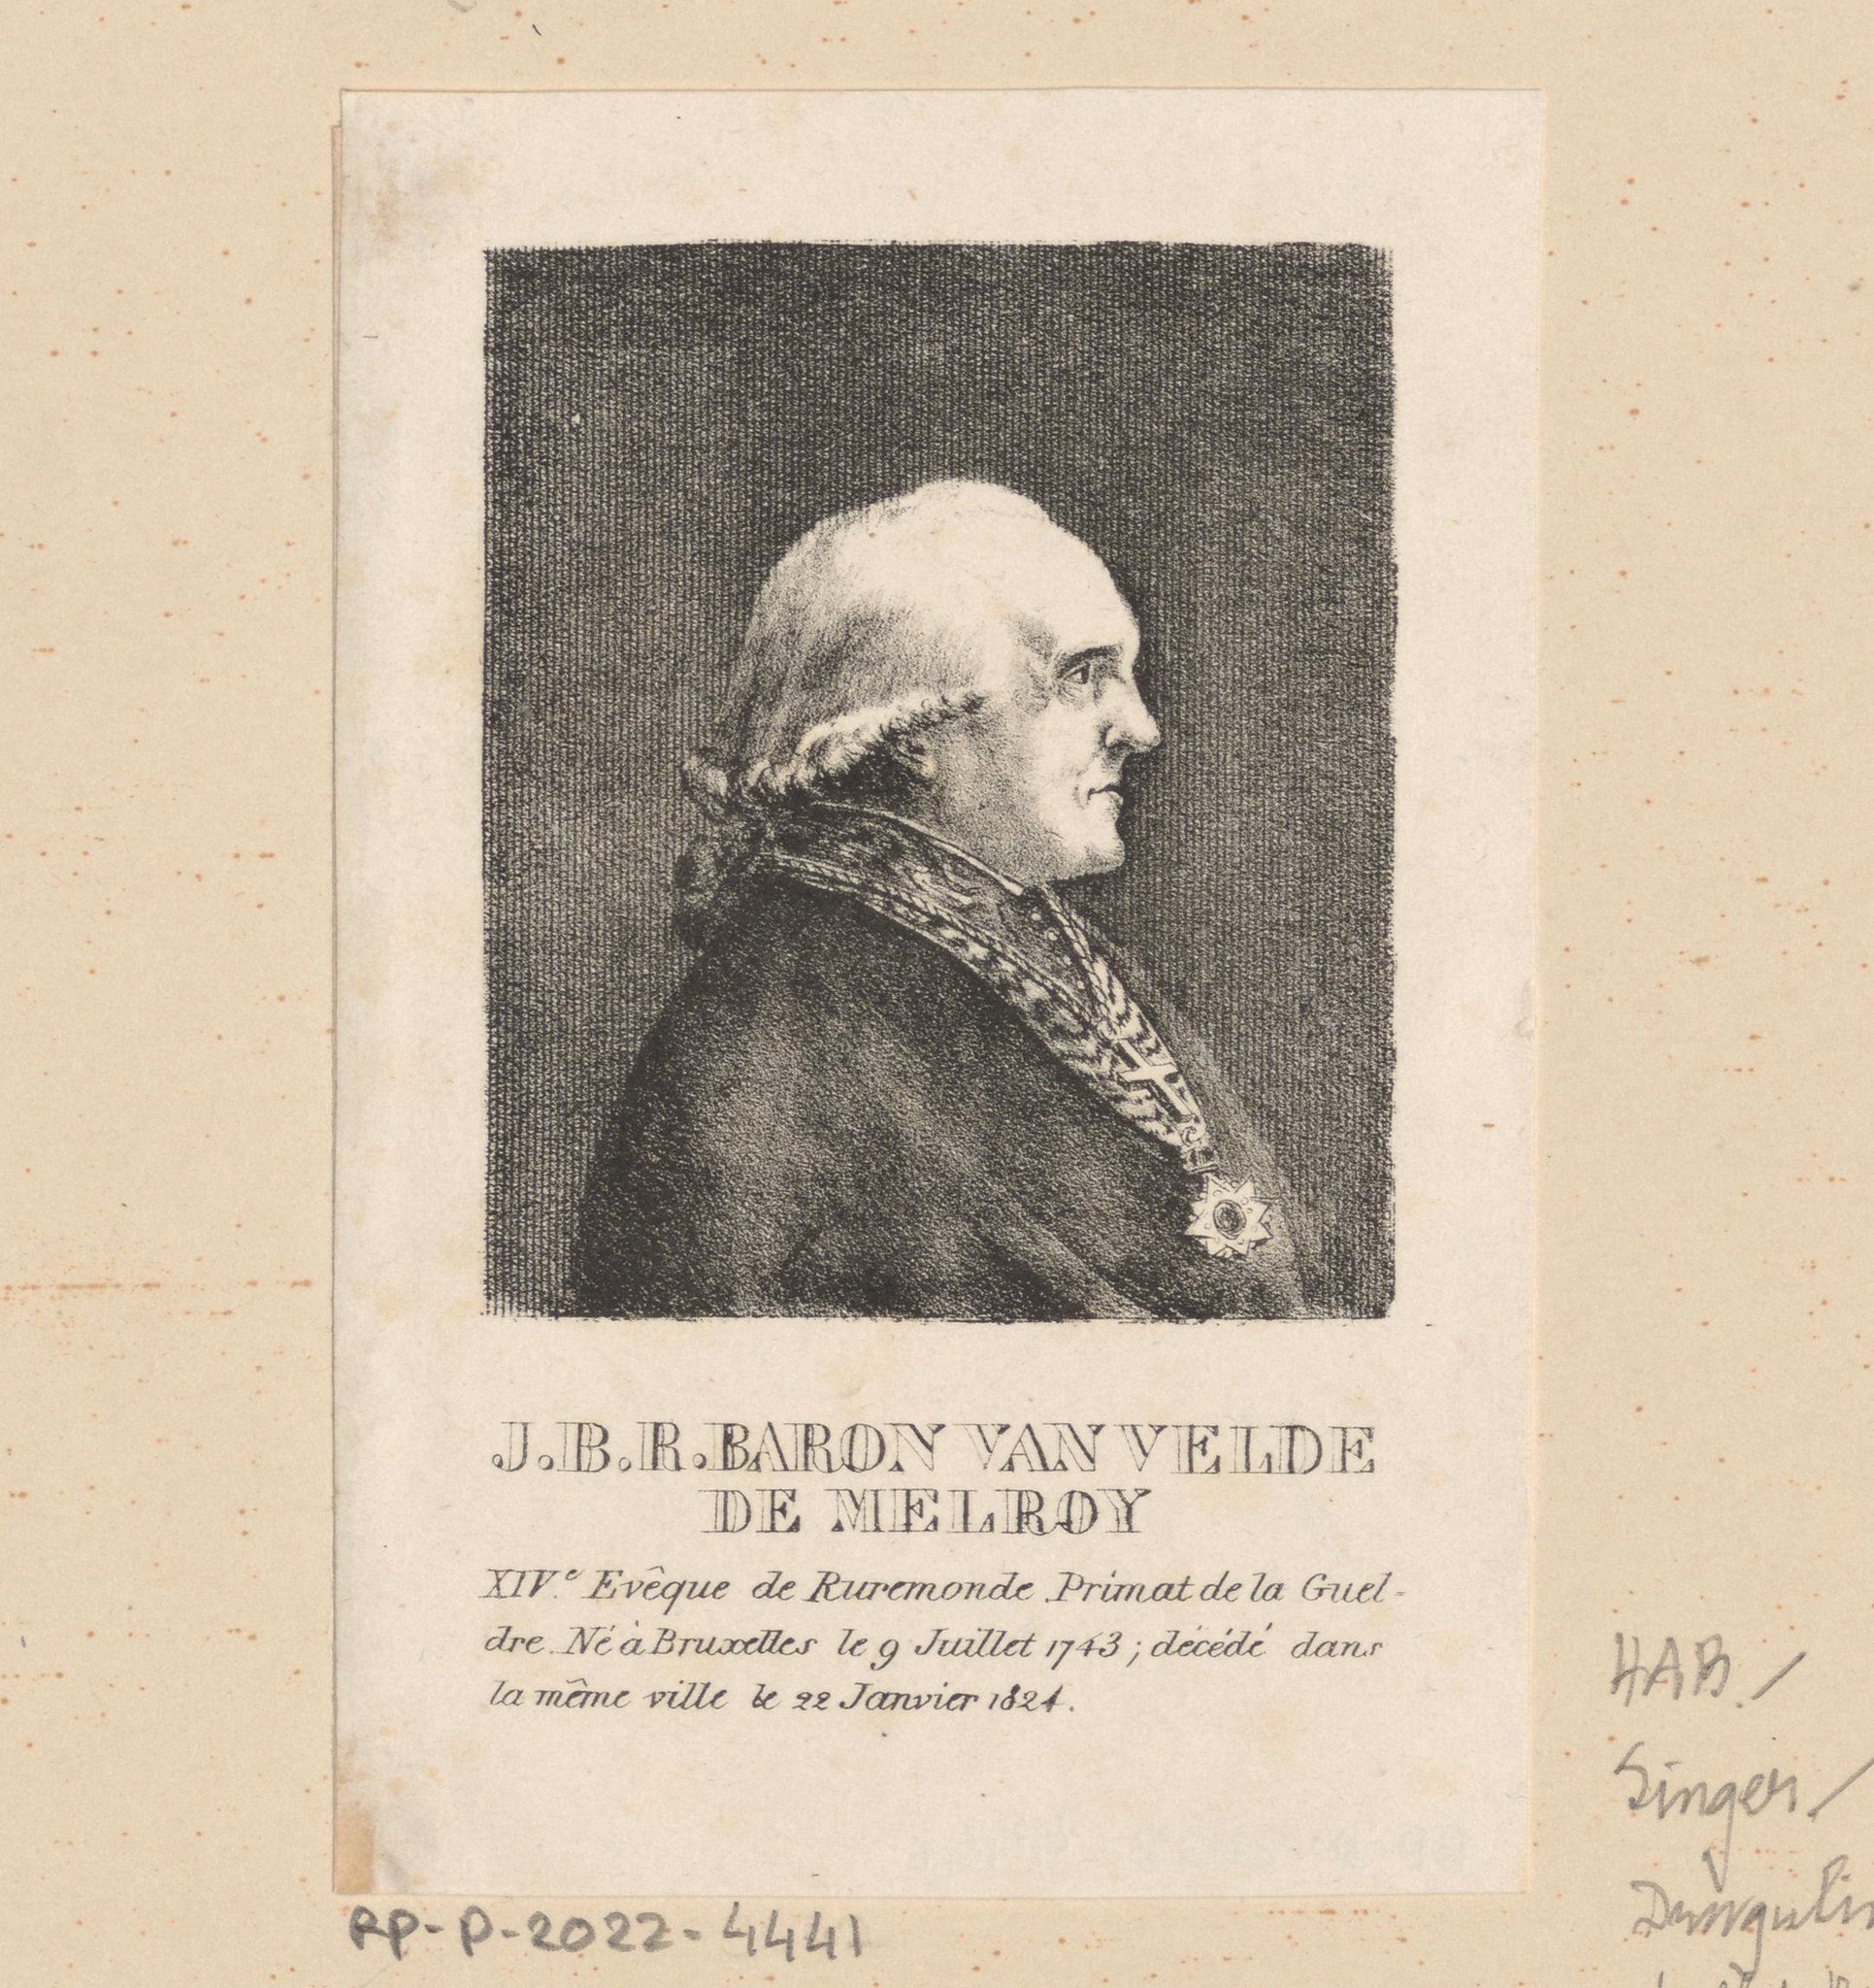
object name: print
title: Portret van Jan Baptist Robert, baron van Velde tot Melroy en Sart-Bomal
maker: Anonymous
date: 1826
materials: paper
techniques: lithograph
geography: southern netherlands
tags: brussels, archbishop, bishop, etc. (roman catholic), historical persons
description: Prent waarschijnlijk uit: Almanach du clergé catholique romain des Pays-Bas. Brussel: Frédéric Maximilien Hayez, 1826.